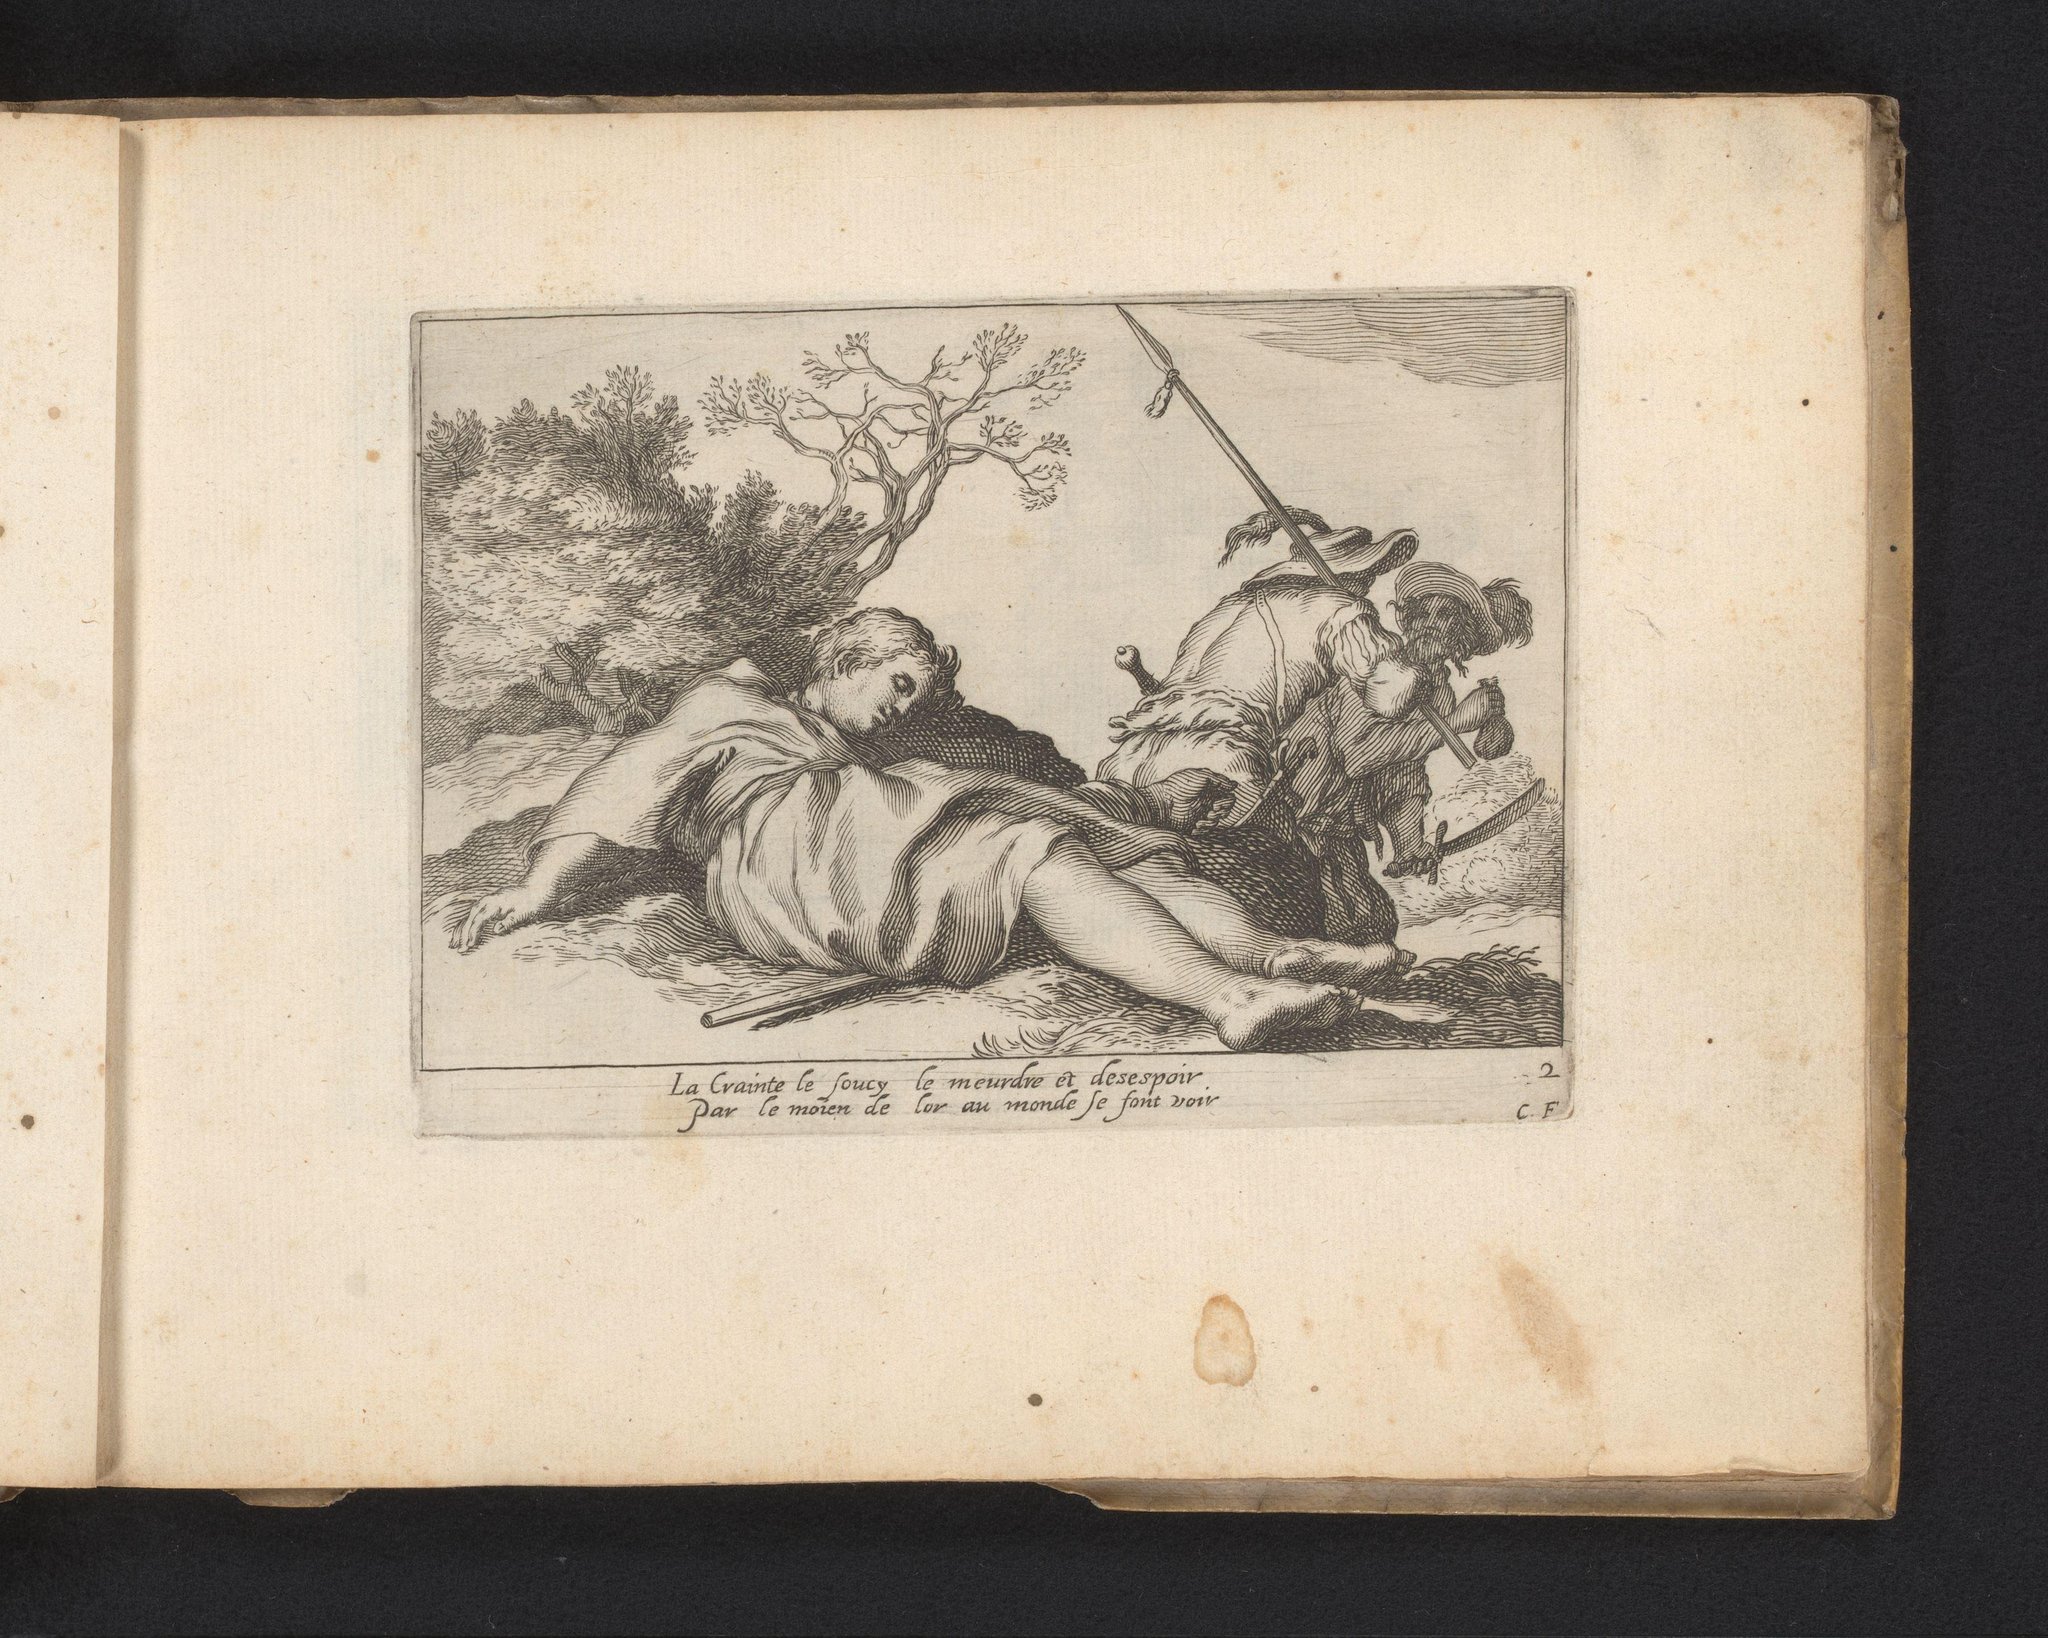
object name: album leaf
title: La Crainte le soucy le meurdre et desespoir par je moien de lor au monde se sont noir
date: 1606-1669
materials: paper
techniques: etching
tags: traveller(s) attacked by robber(s), robbery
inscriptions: collector's mark: ‘Bibliotheek/ Rijksmuseum/ Amsterdam’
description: Deze prent maakt deel uit van een album.